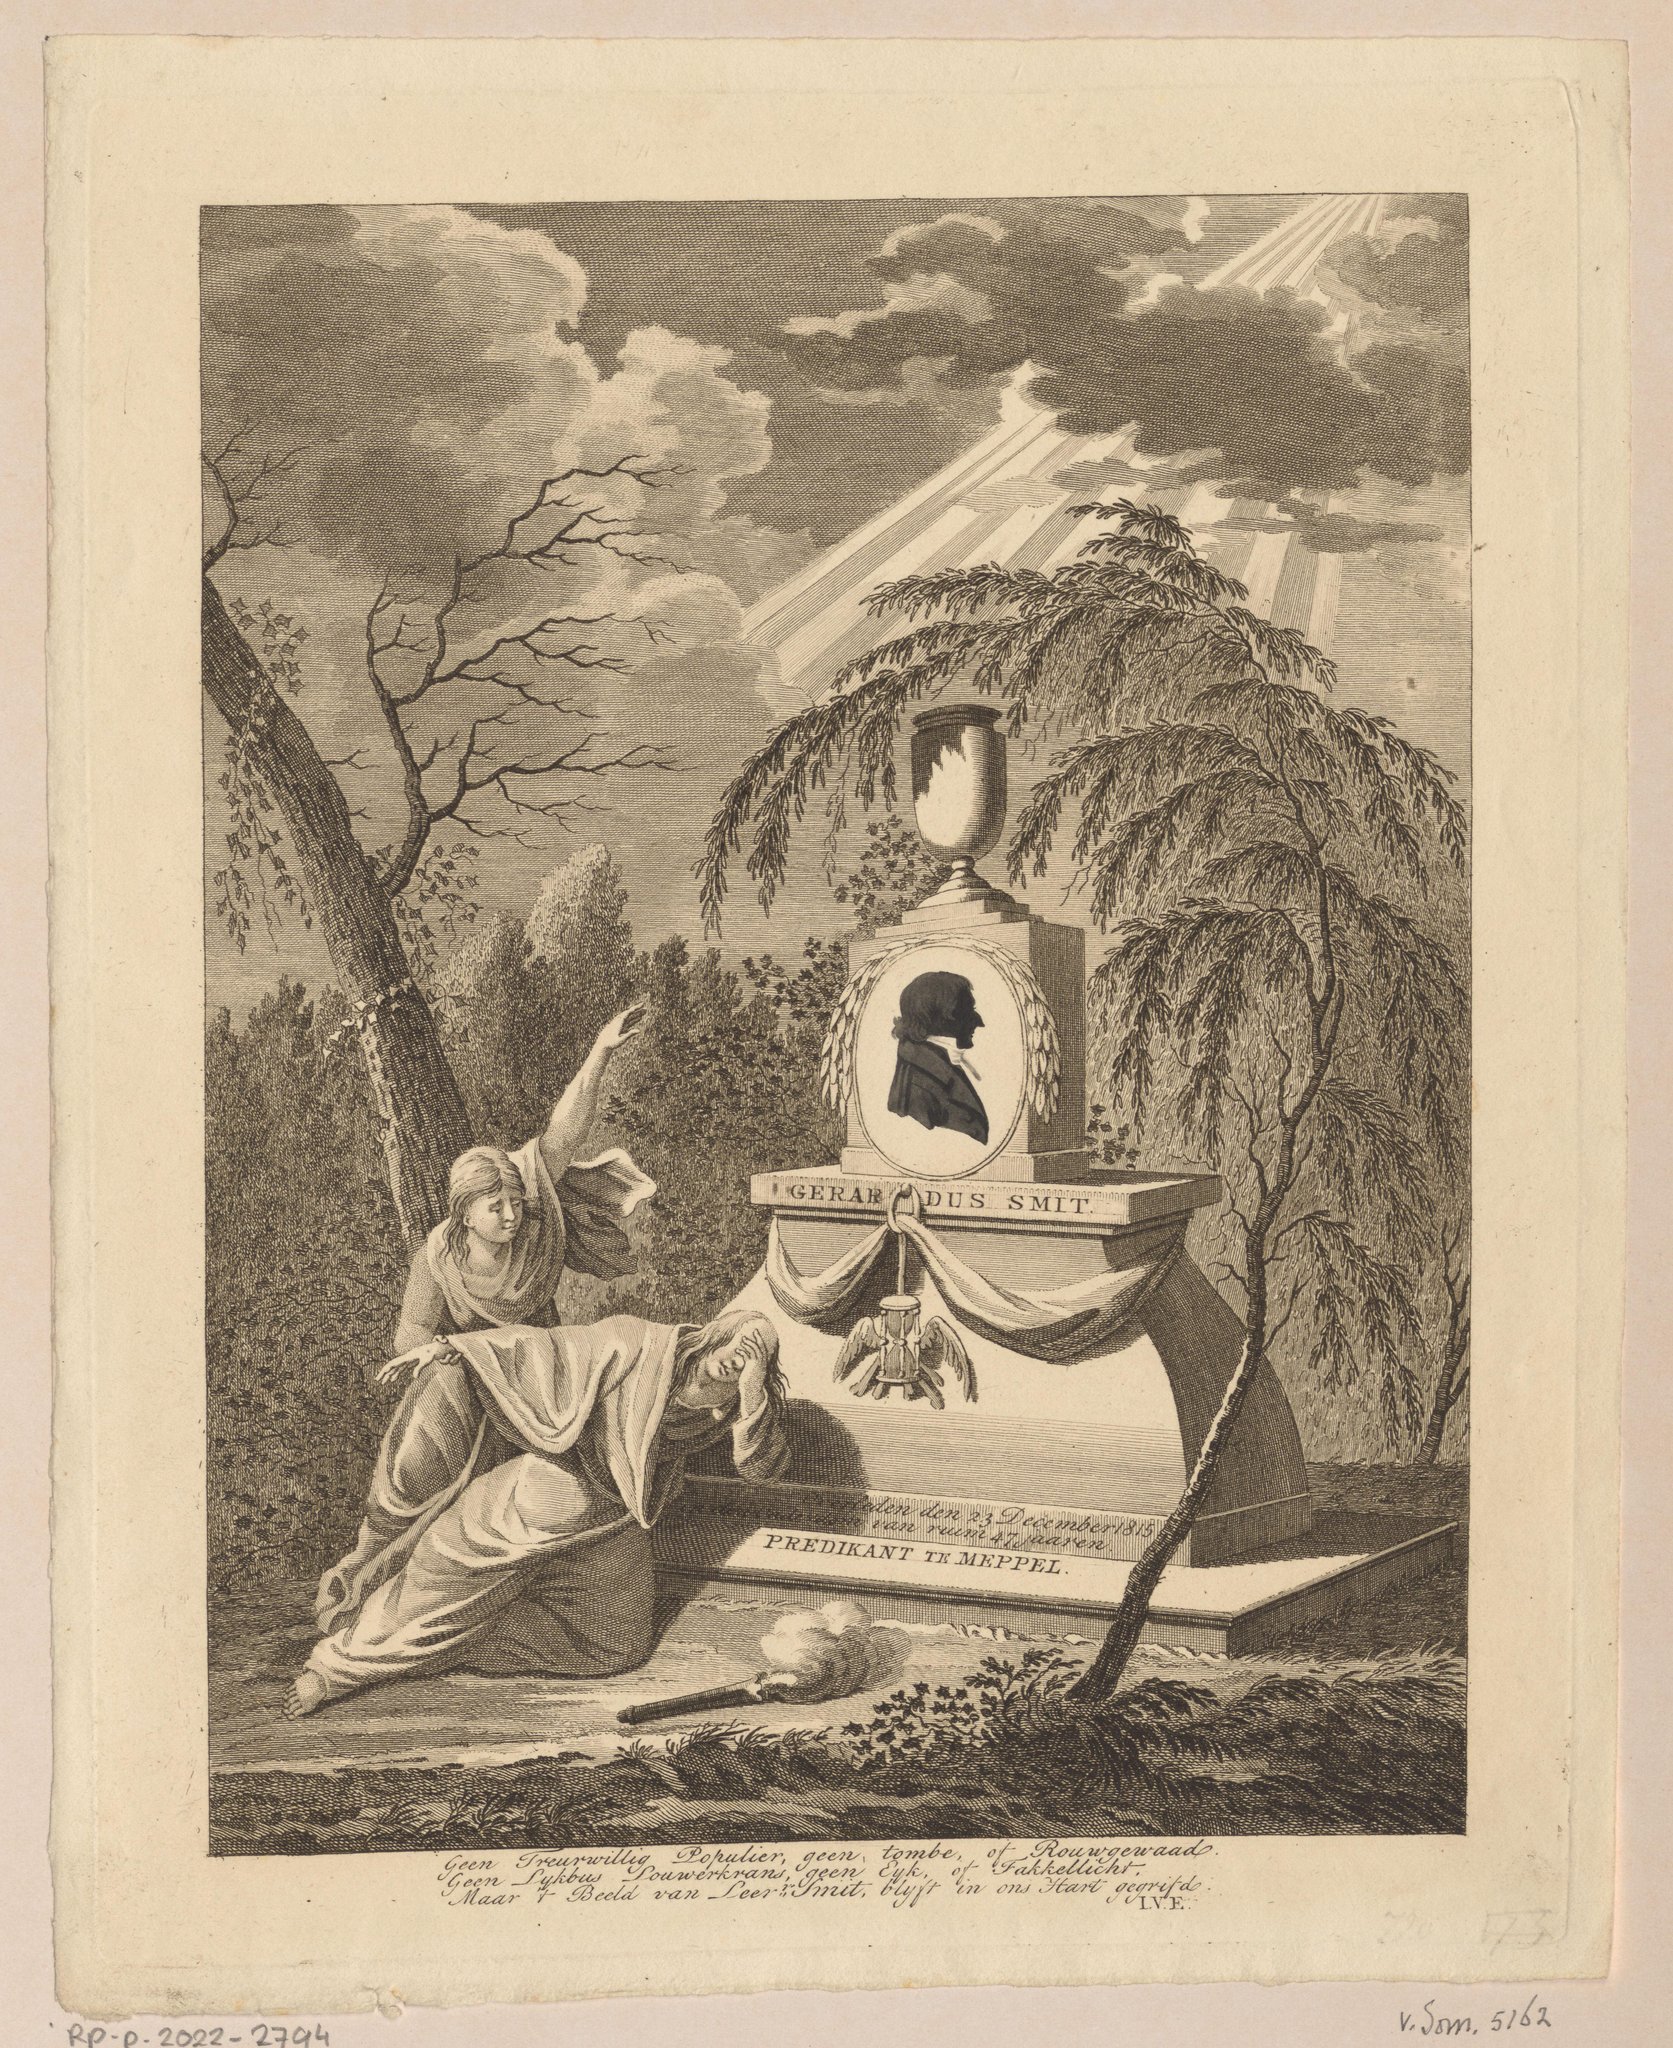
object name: print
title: Portret van Gerardus Smit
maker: Anonymous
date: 1815-1899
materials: ink, paper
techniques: brush, etching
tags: historical persons, functionaries and dignitaries (with name) ~ episcopal protestant churches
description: Met drieregelig onderschrift in het Nederlands.